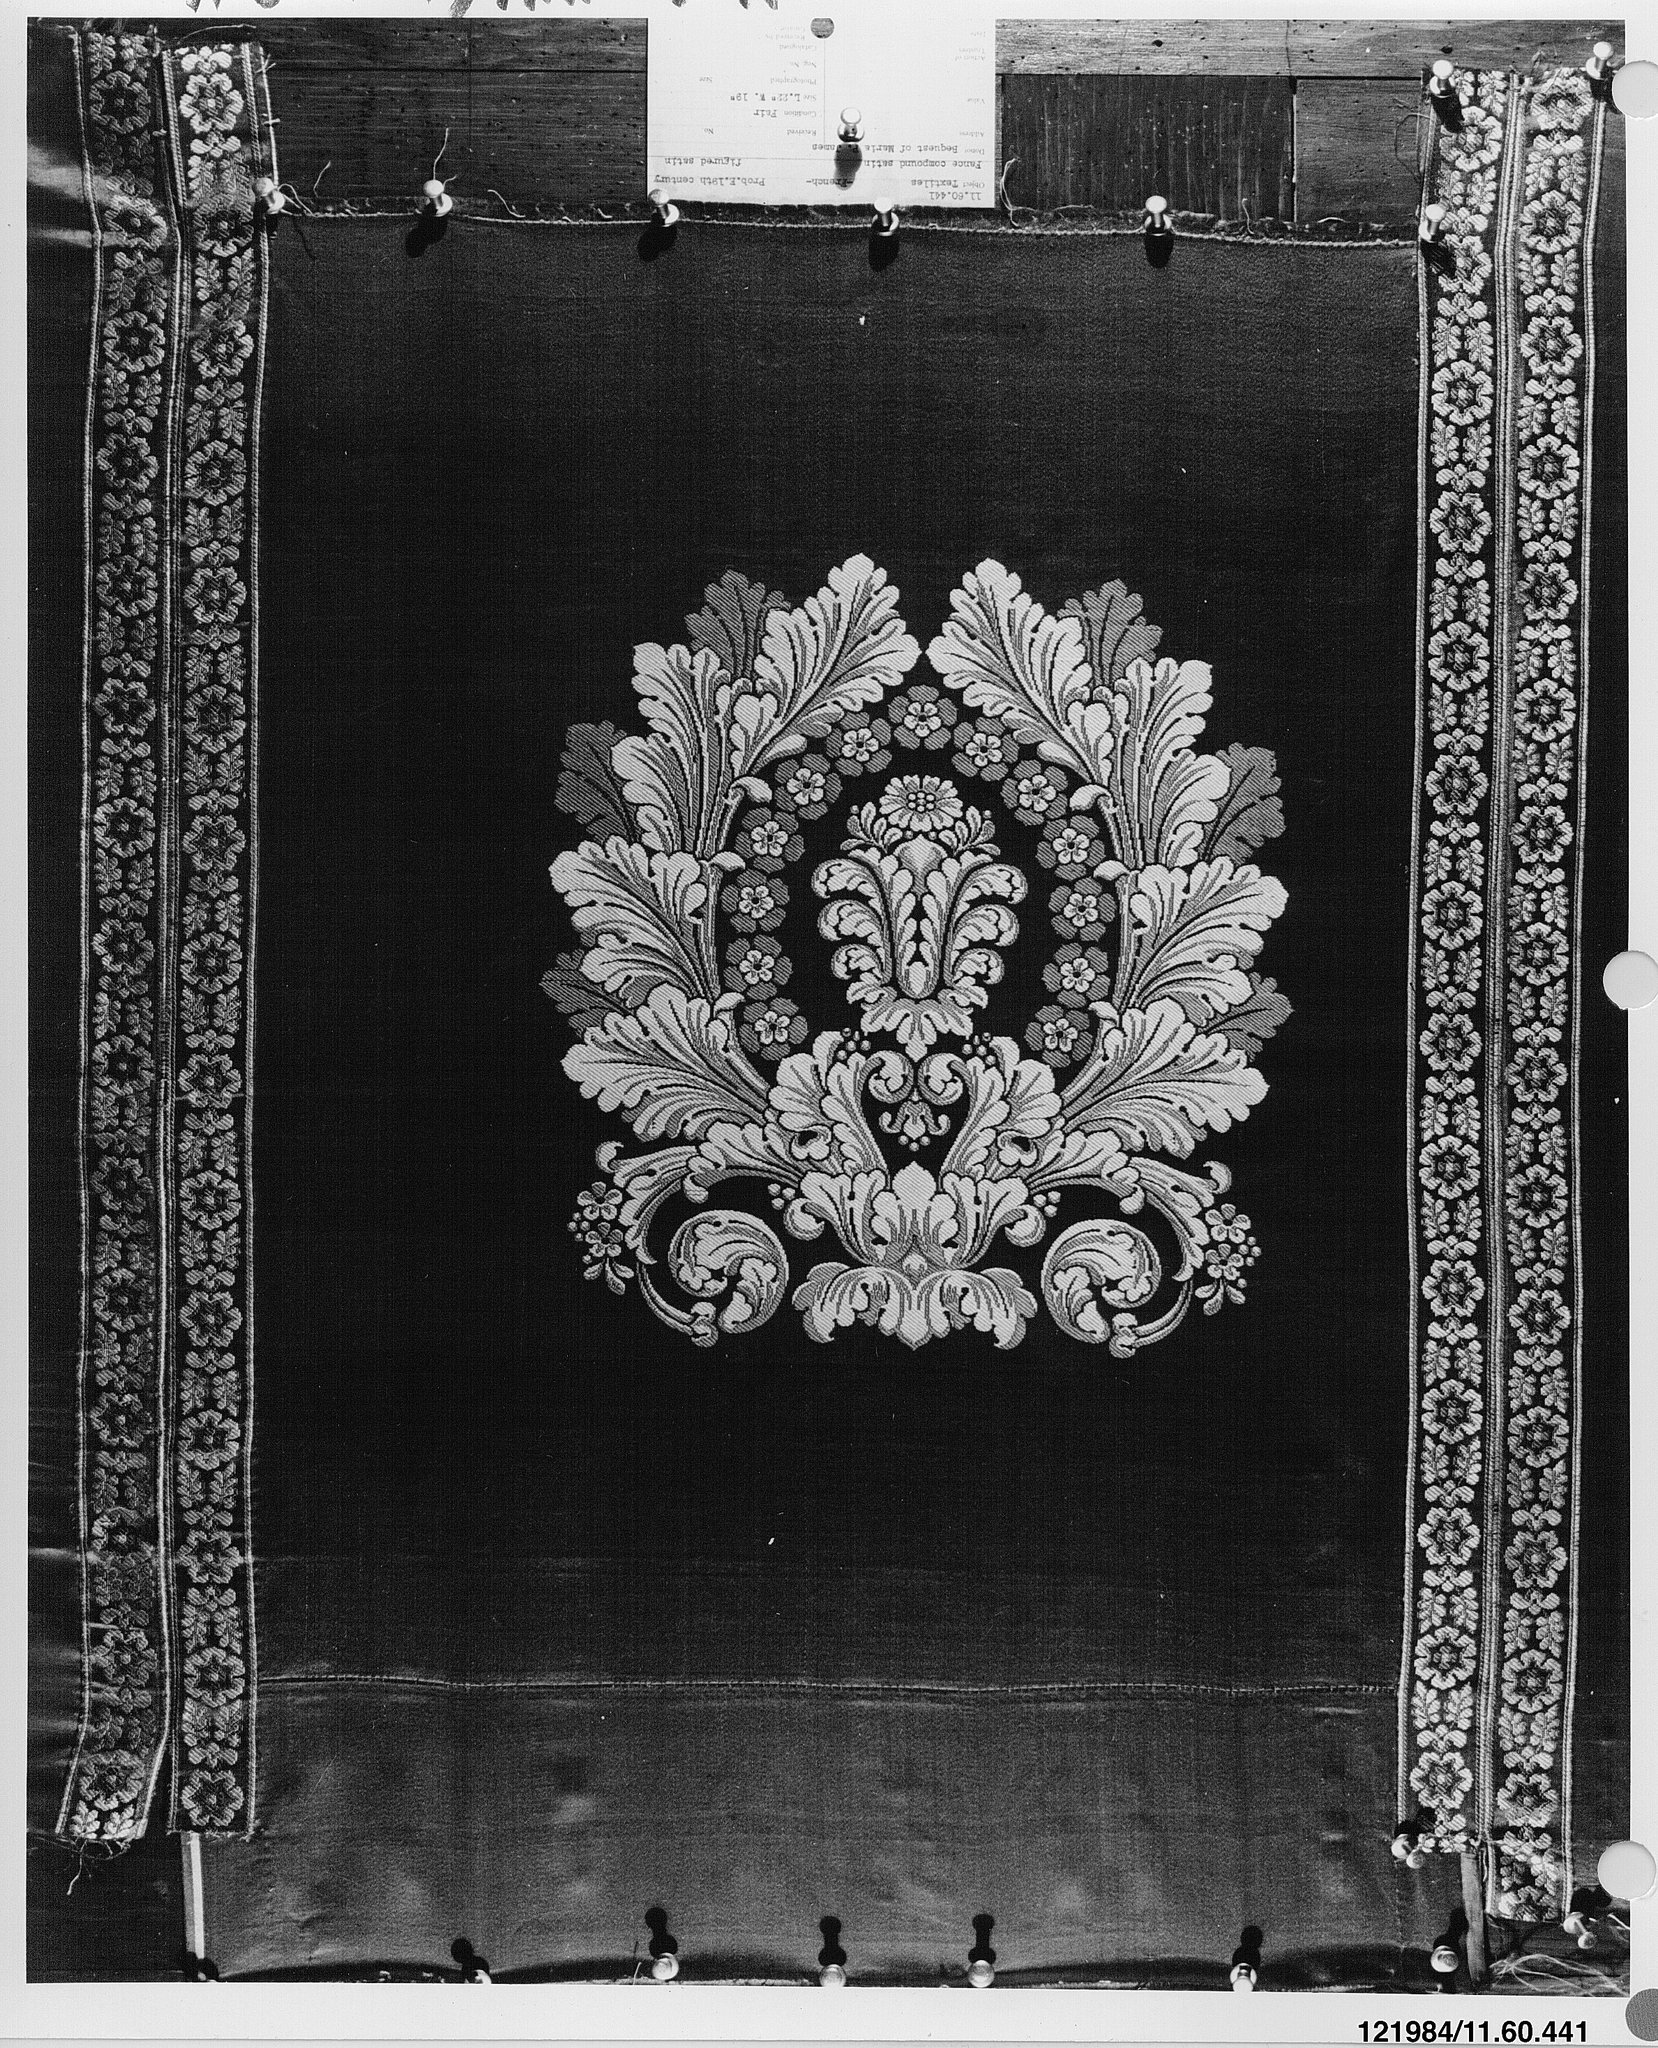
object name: piece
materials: silk